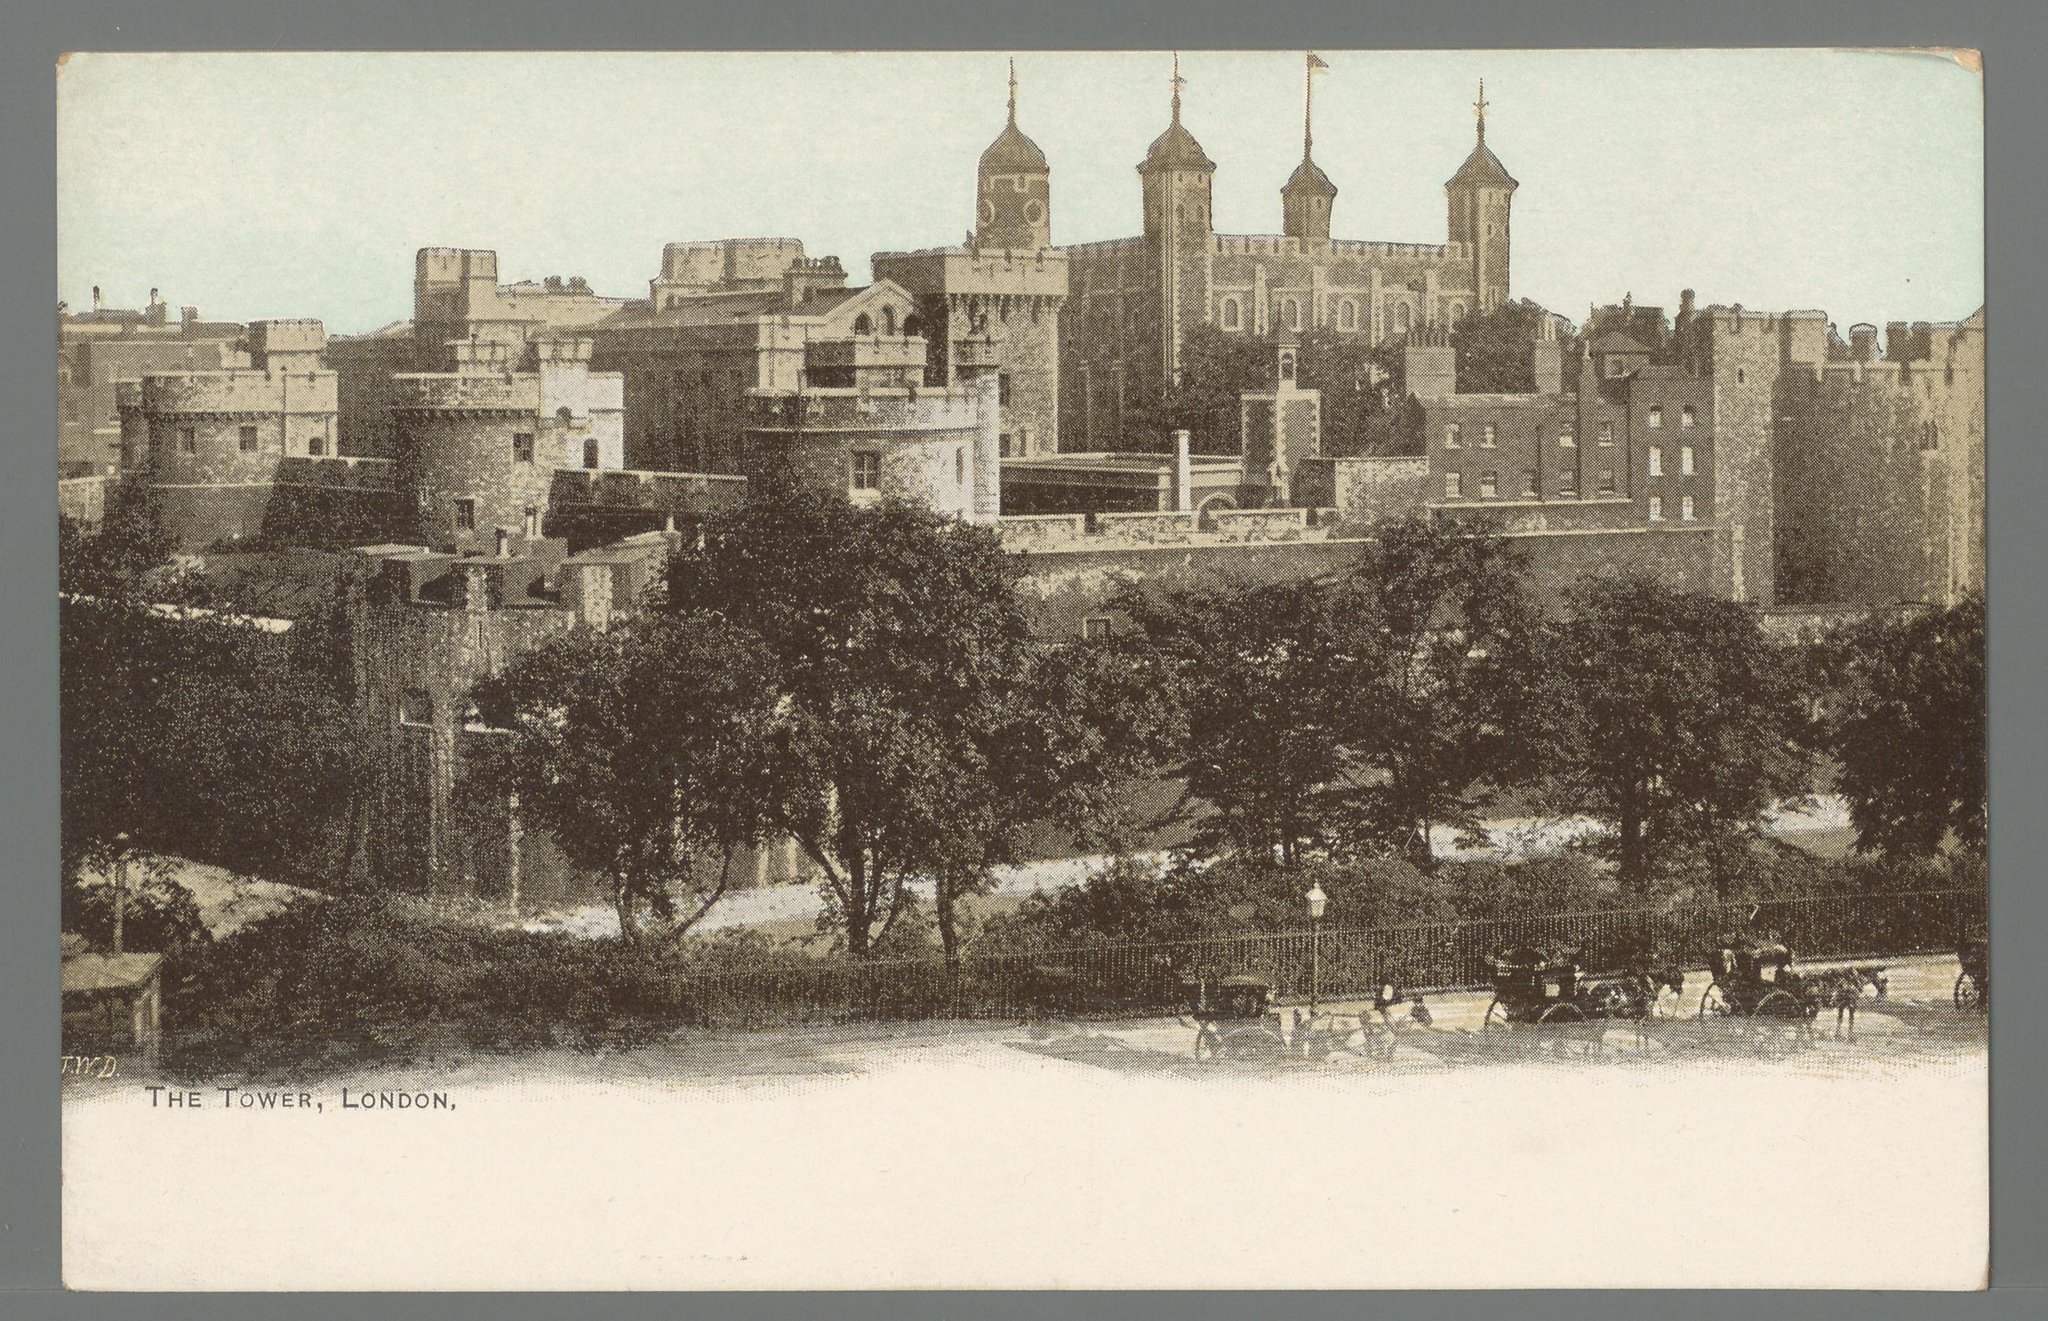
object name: photomechanical print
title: The Tower, London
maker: j.w.d.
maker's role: maker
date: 1902-1930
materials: cardboard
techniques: autotype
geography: london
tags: castle